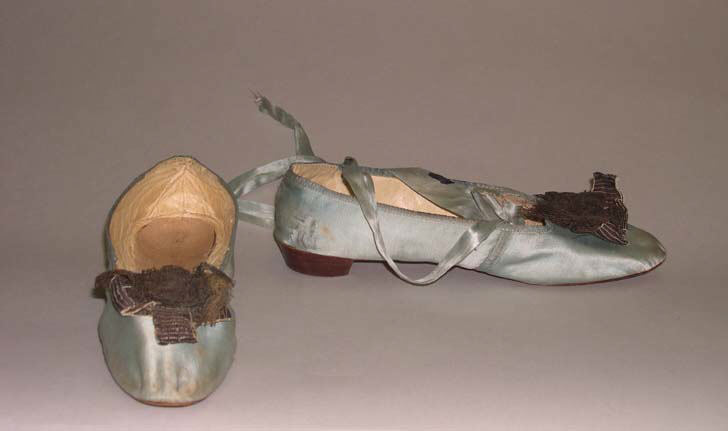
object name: slipper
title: Slippers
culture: american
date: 1810-1819